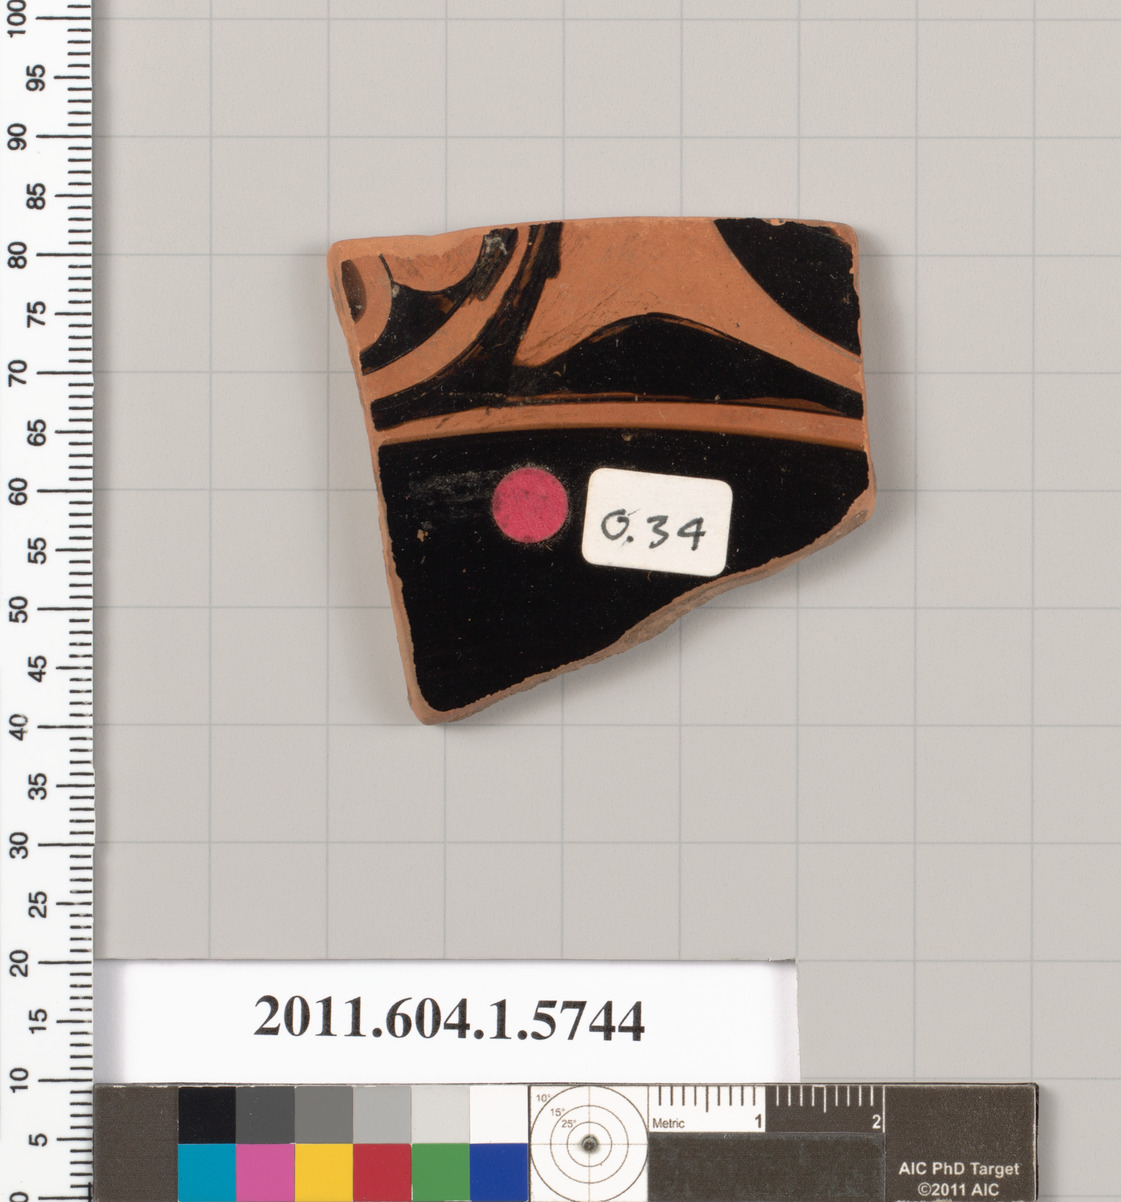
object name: kylix fragment, eye cup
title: Terracotta fragment of a kylix: eye-cup (drinking cup)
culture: greek, attic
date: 525-510 BCE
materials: terracotta